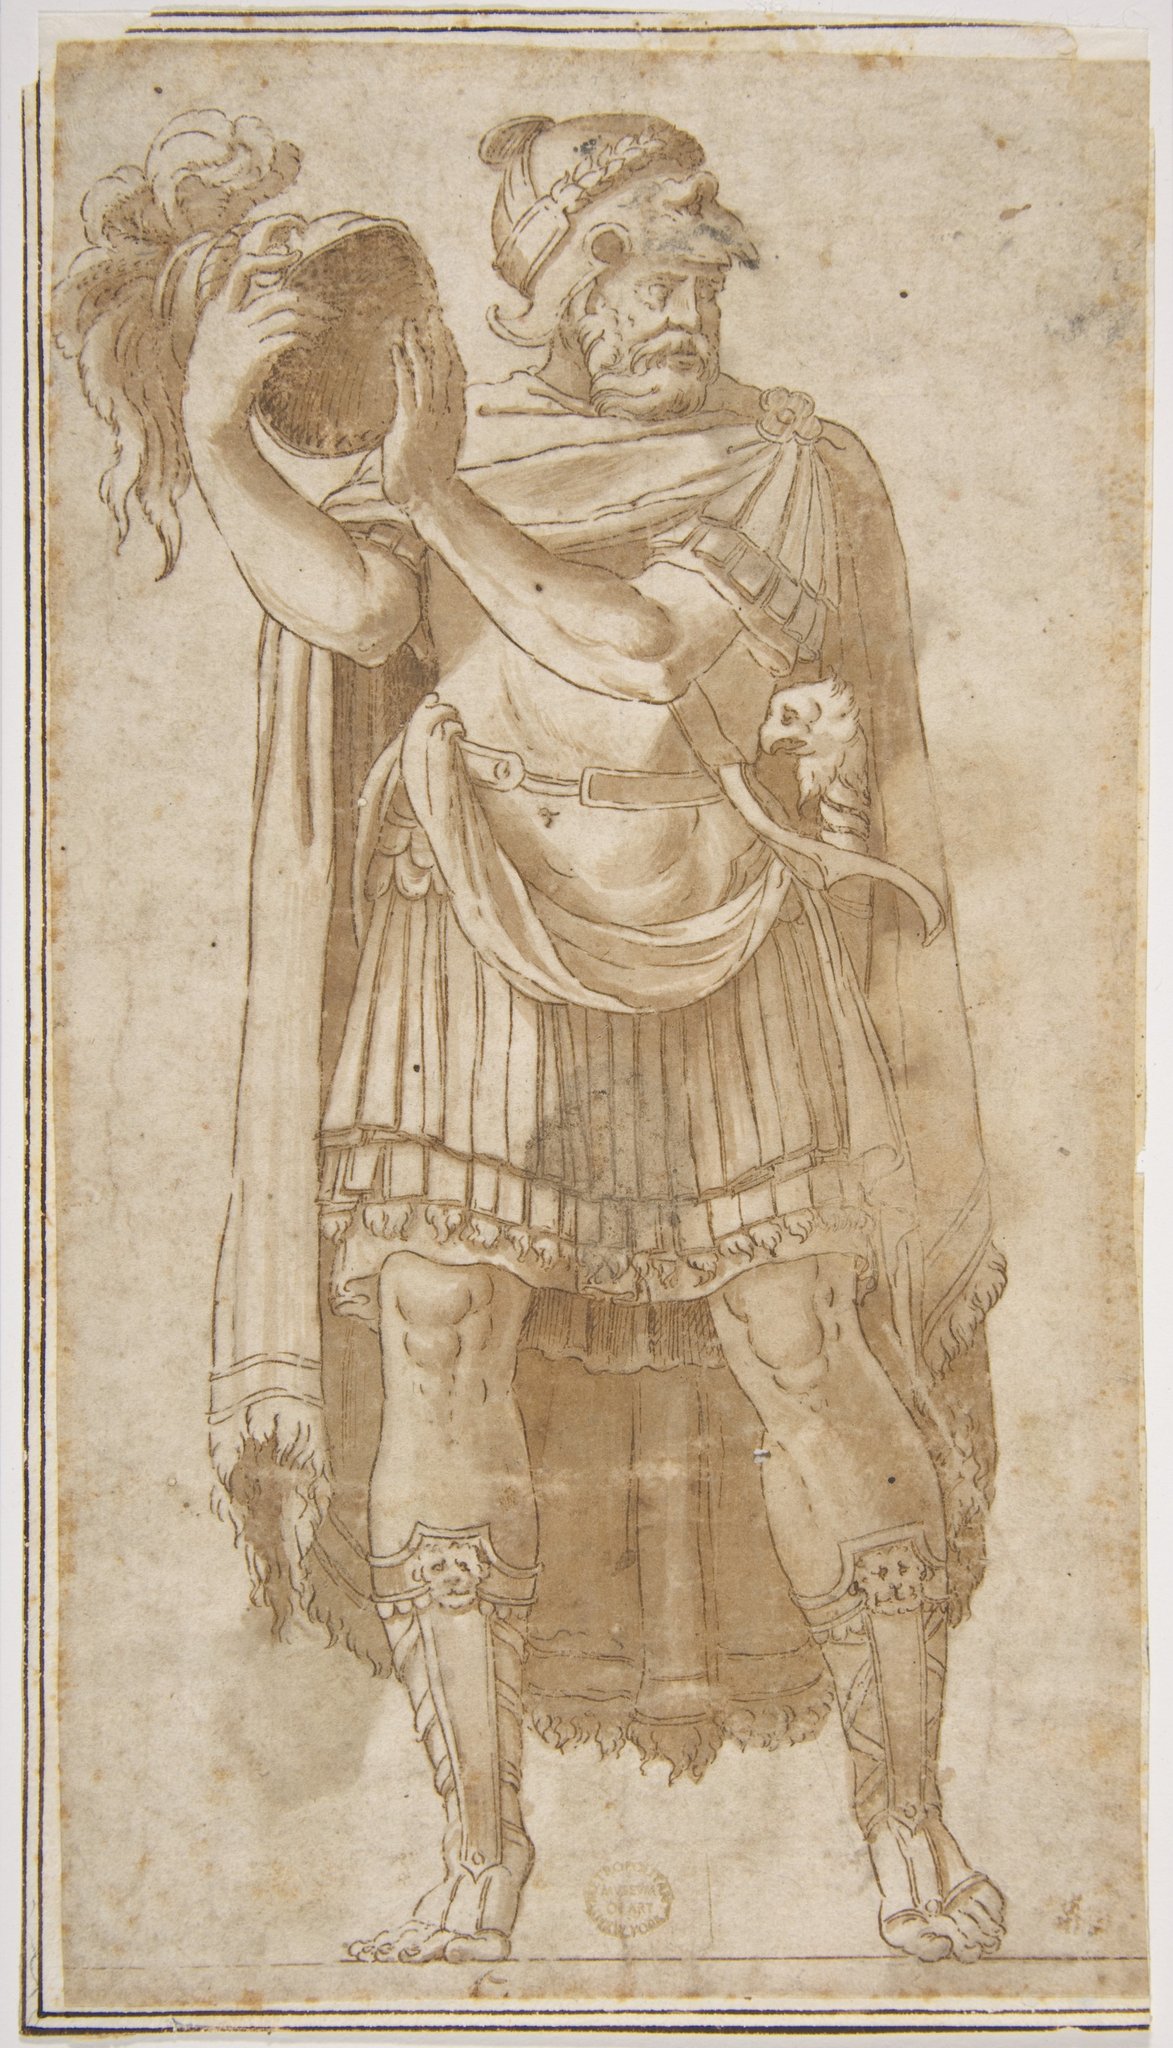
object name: drawing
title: Soldier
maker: polidoro da caravaggio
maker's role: artist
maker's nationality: italian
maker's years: 1494-1548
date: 1499-1543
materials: ink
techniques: brush, pen, wash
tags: soldiers,helmets,men